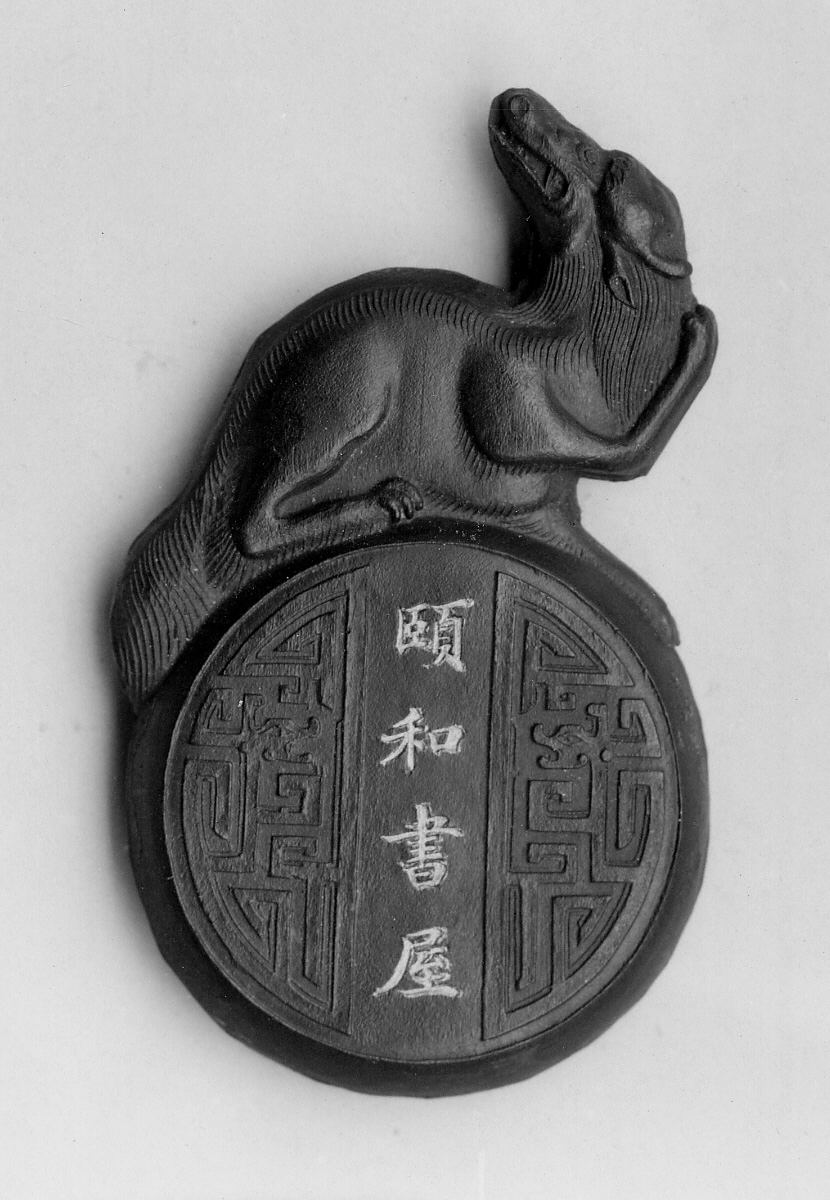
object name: ink tablet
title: The Restful Harmony Library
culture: chinese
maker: jian guzhai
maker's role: artist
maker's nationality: chinese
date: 1867-1933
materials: gilt, wood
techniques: bookbinding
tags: animals